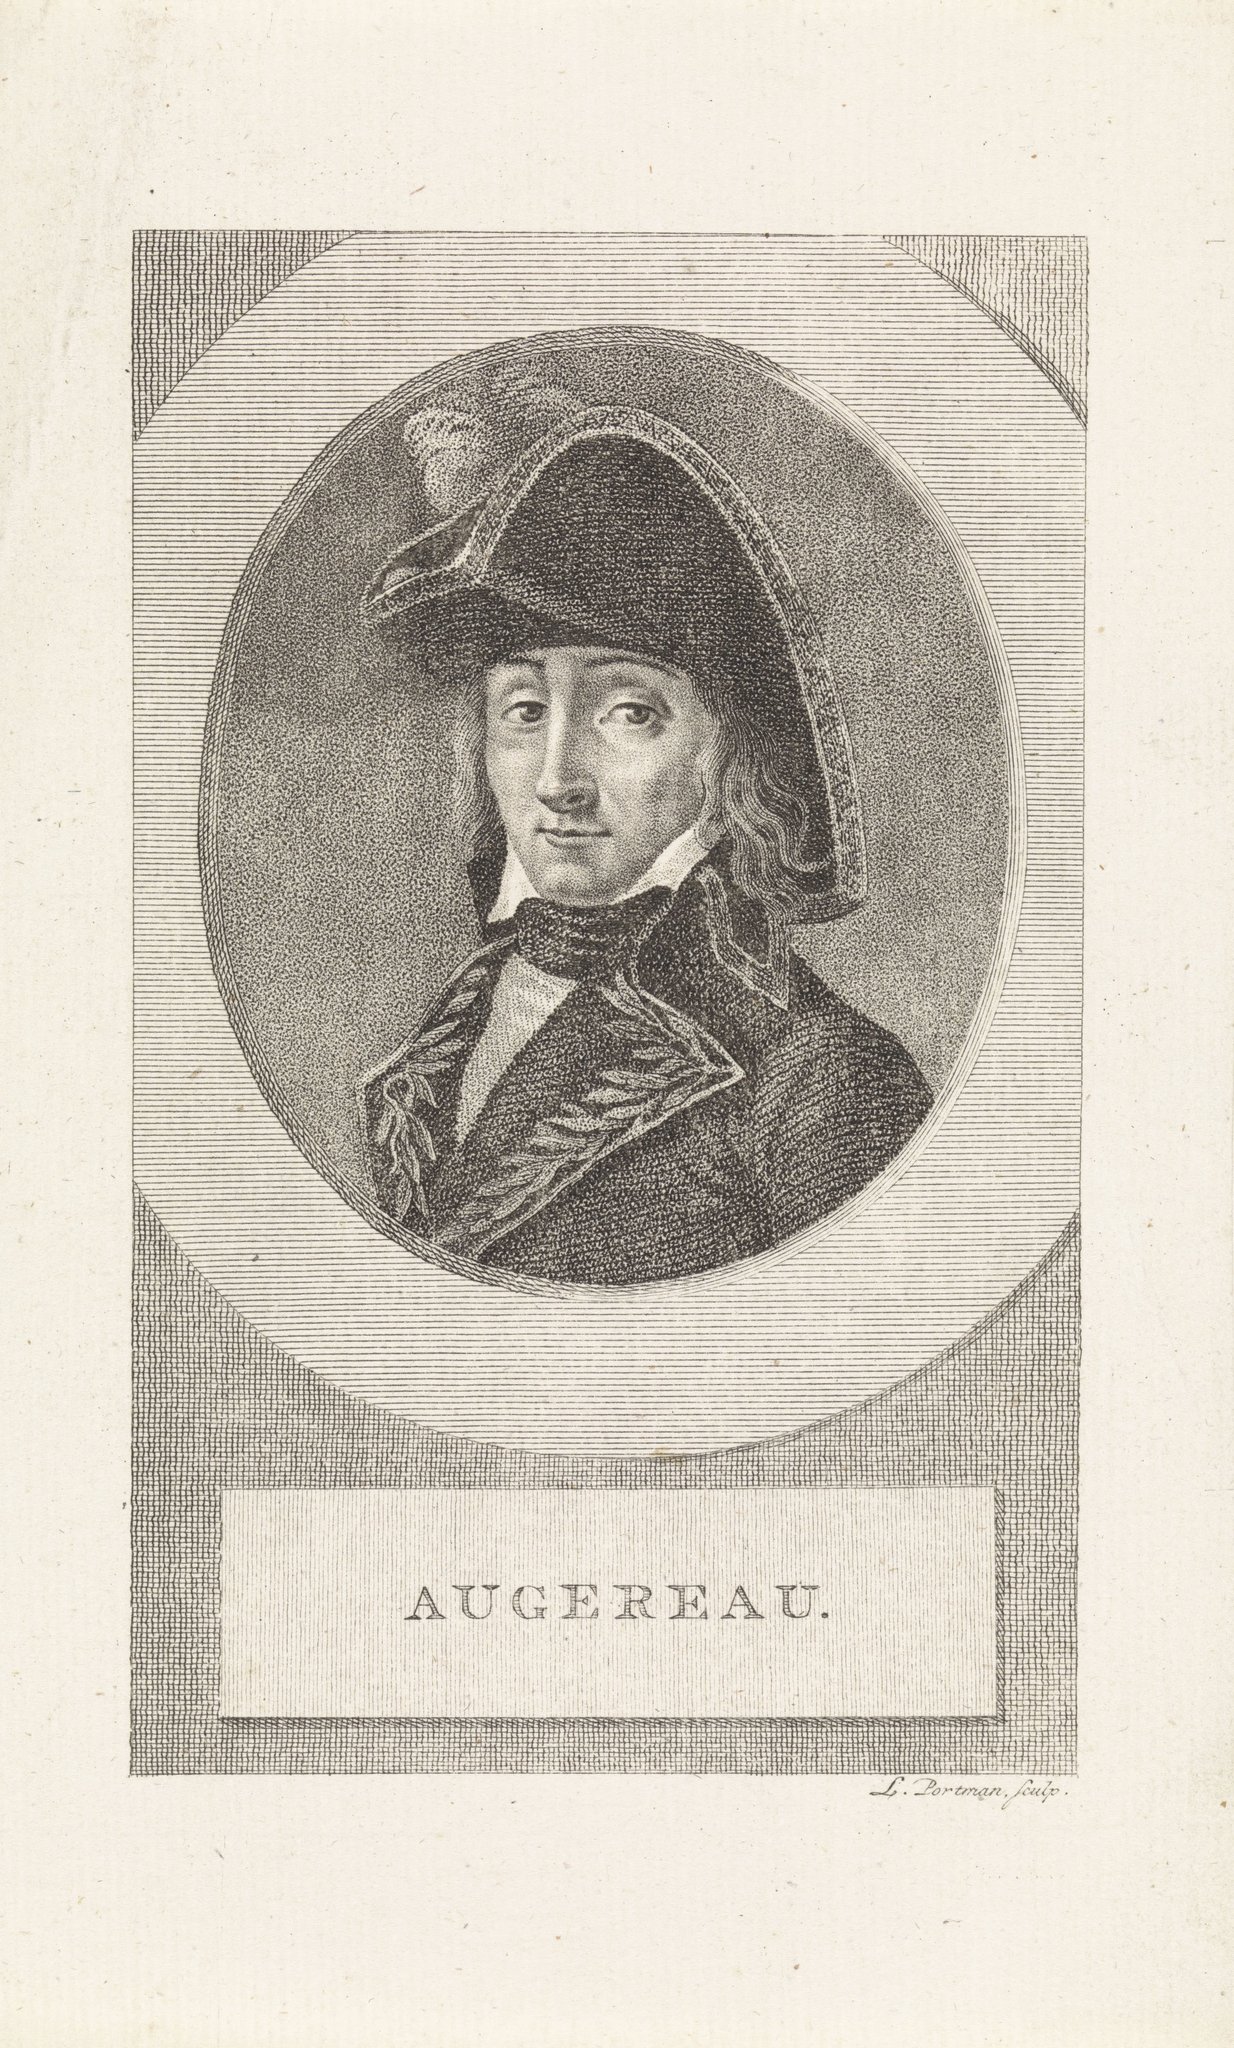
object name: print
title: Portret van Pierre François Charles Augereau, maarschalk van Frankrijk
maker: ludwig gottlieb portman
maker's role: print maker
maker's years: 1772-1828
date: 1807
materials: paper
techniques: stippled etching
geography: amsterdam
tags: paris, politician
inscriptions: collector's mark: Lugt 2228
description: Prent ook gebruikt als illustratie in: Tafereelen van de staatsomwenteling in Frankrijk, deel 24, p. 222. Amsterdam: Johannes Allart, 1807.